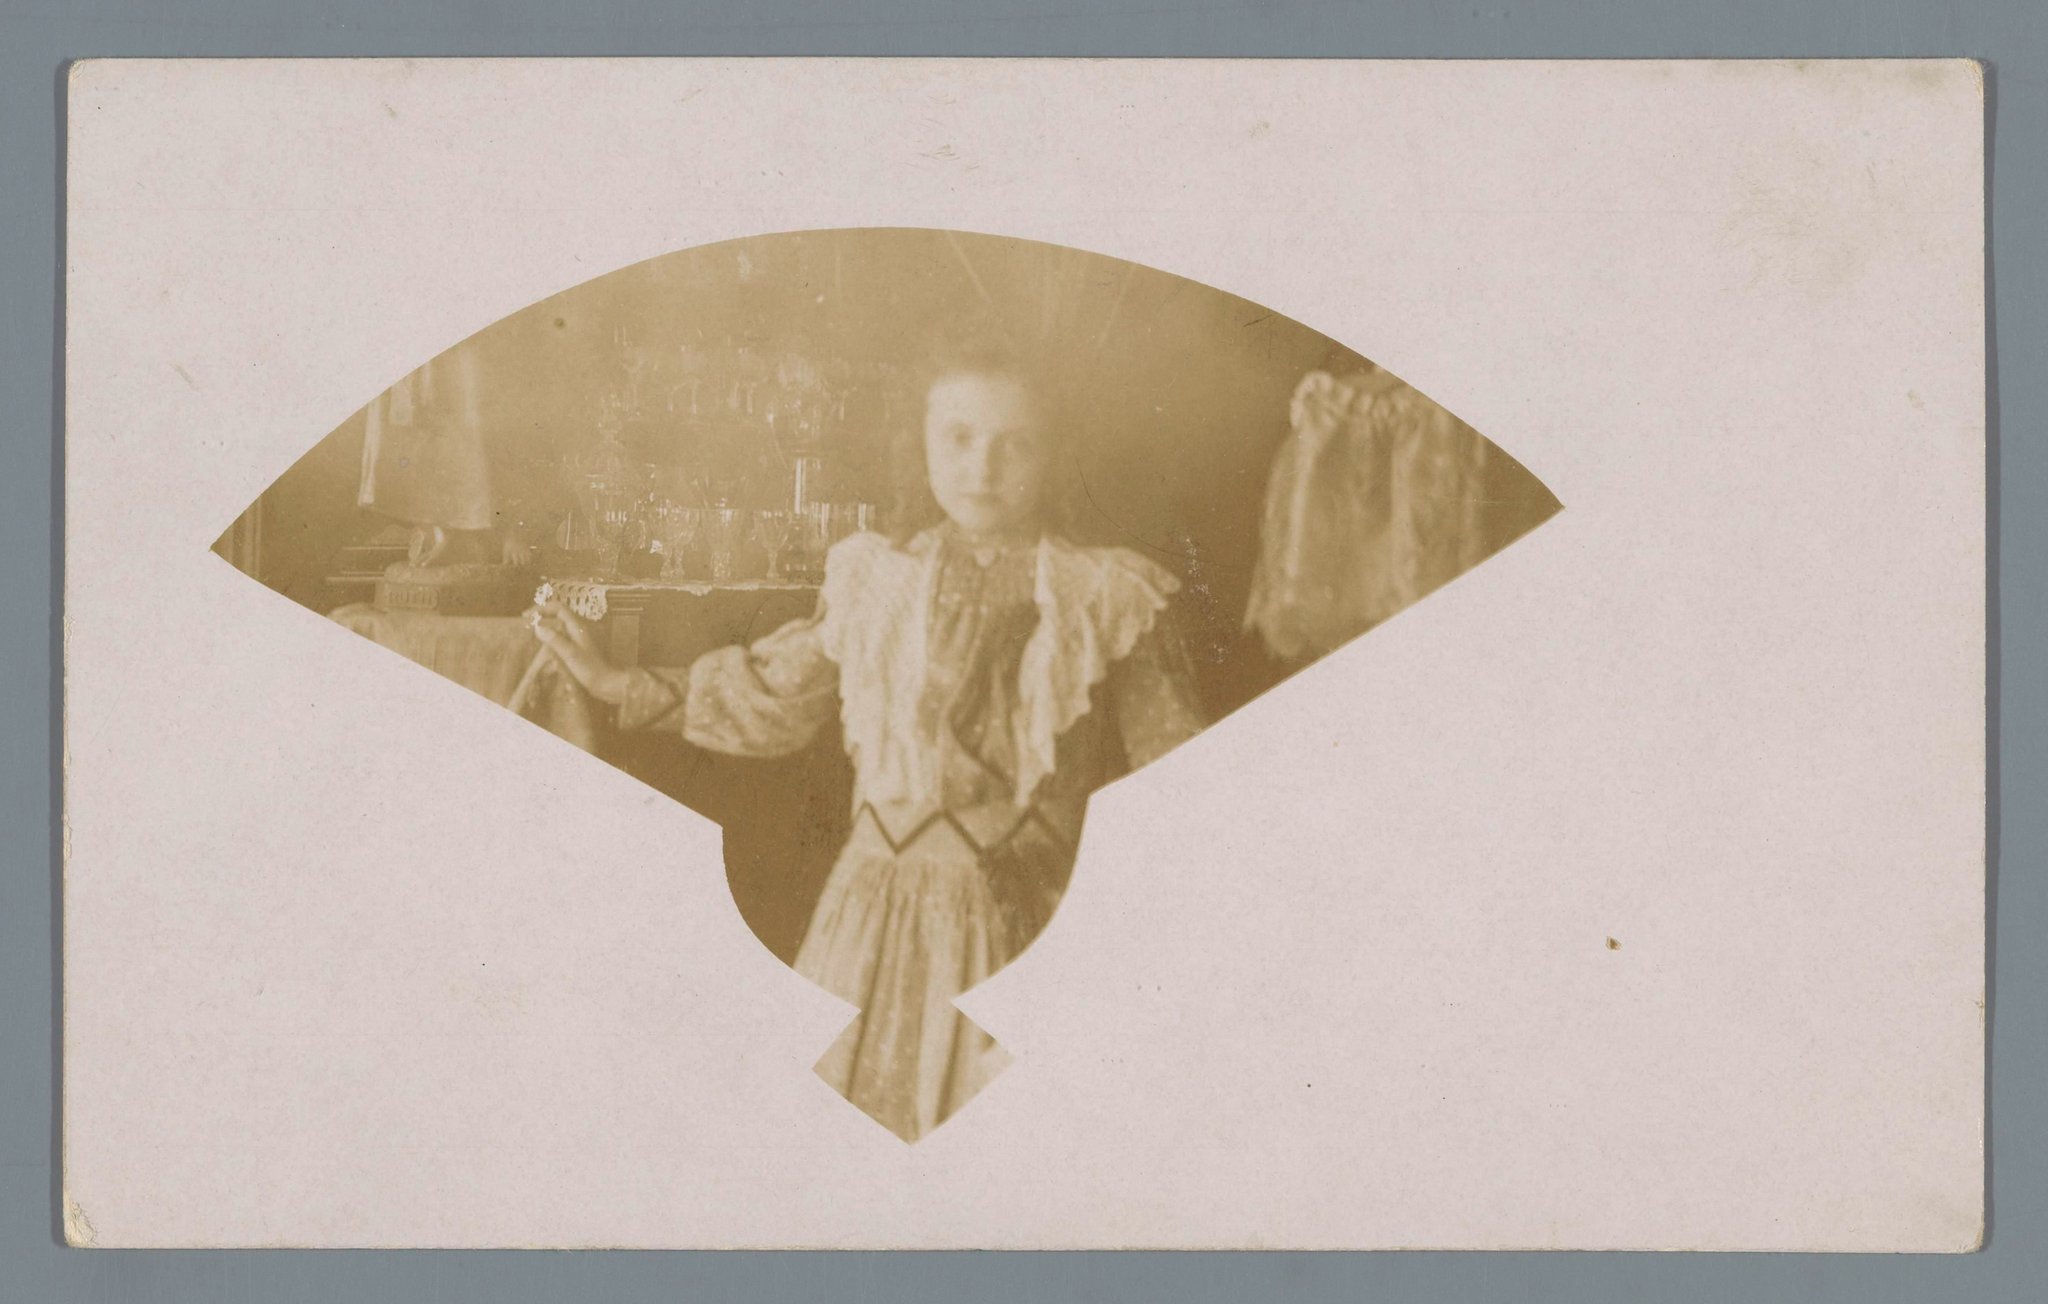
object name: photograph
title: Portret van een onbekend meisje in een interieur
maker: Anonymous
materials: photographic support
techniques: gelatin silver print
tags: girl (child between toddler and youth), interior ~ representation of a building